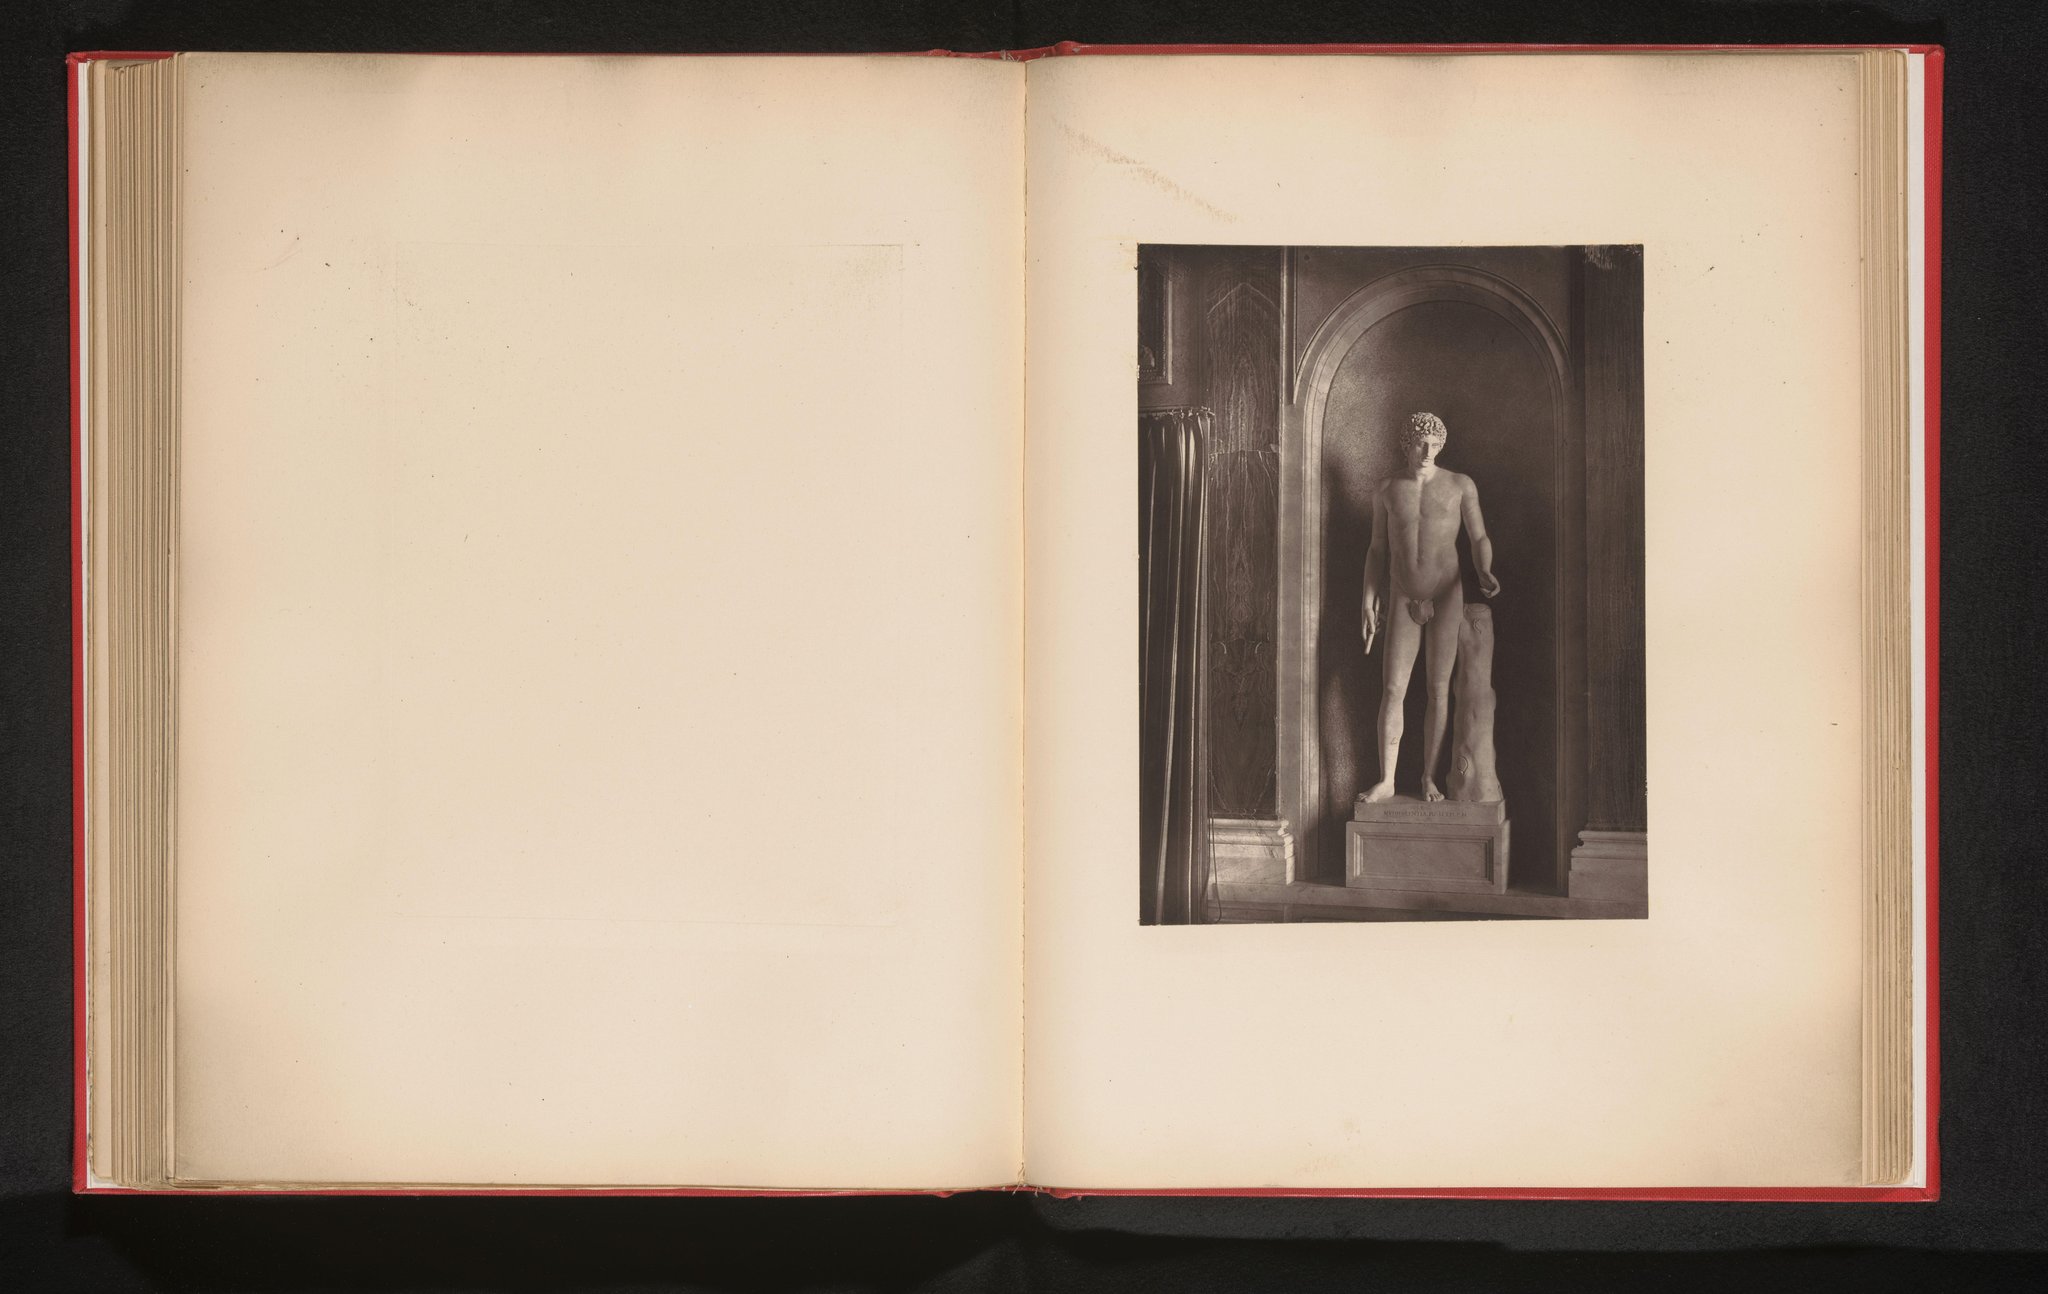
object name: page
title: Standbeeld van Adonis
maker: stephen thompson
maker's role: fotograaf, schrijver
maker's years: 1831-1893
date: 1873-1878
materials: paper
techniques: woodburytype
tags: (story of) adonis, sculpture